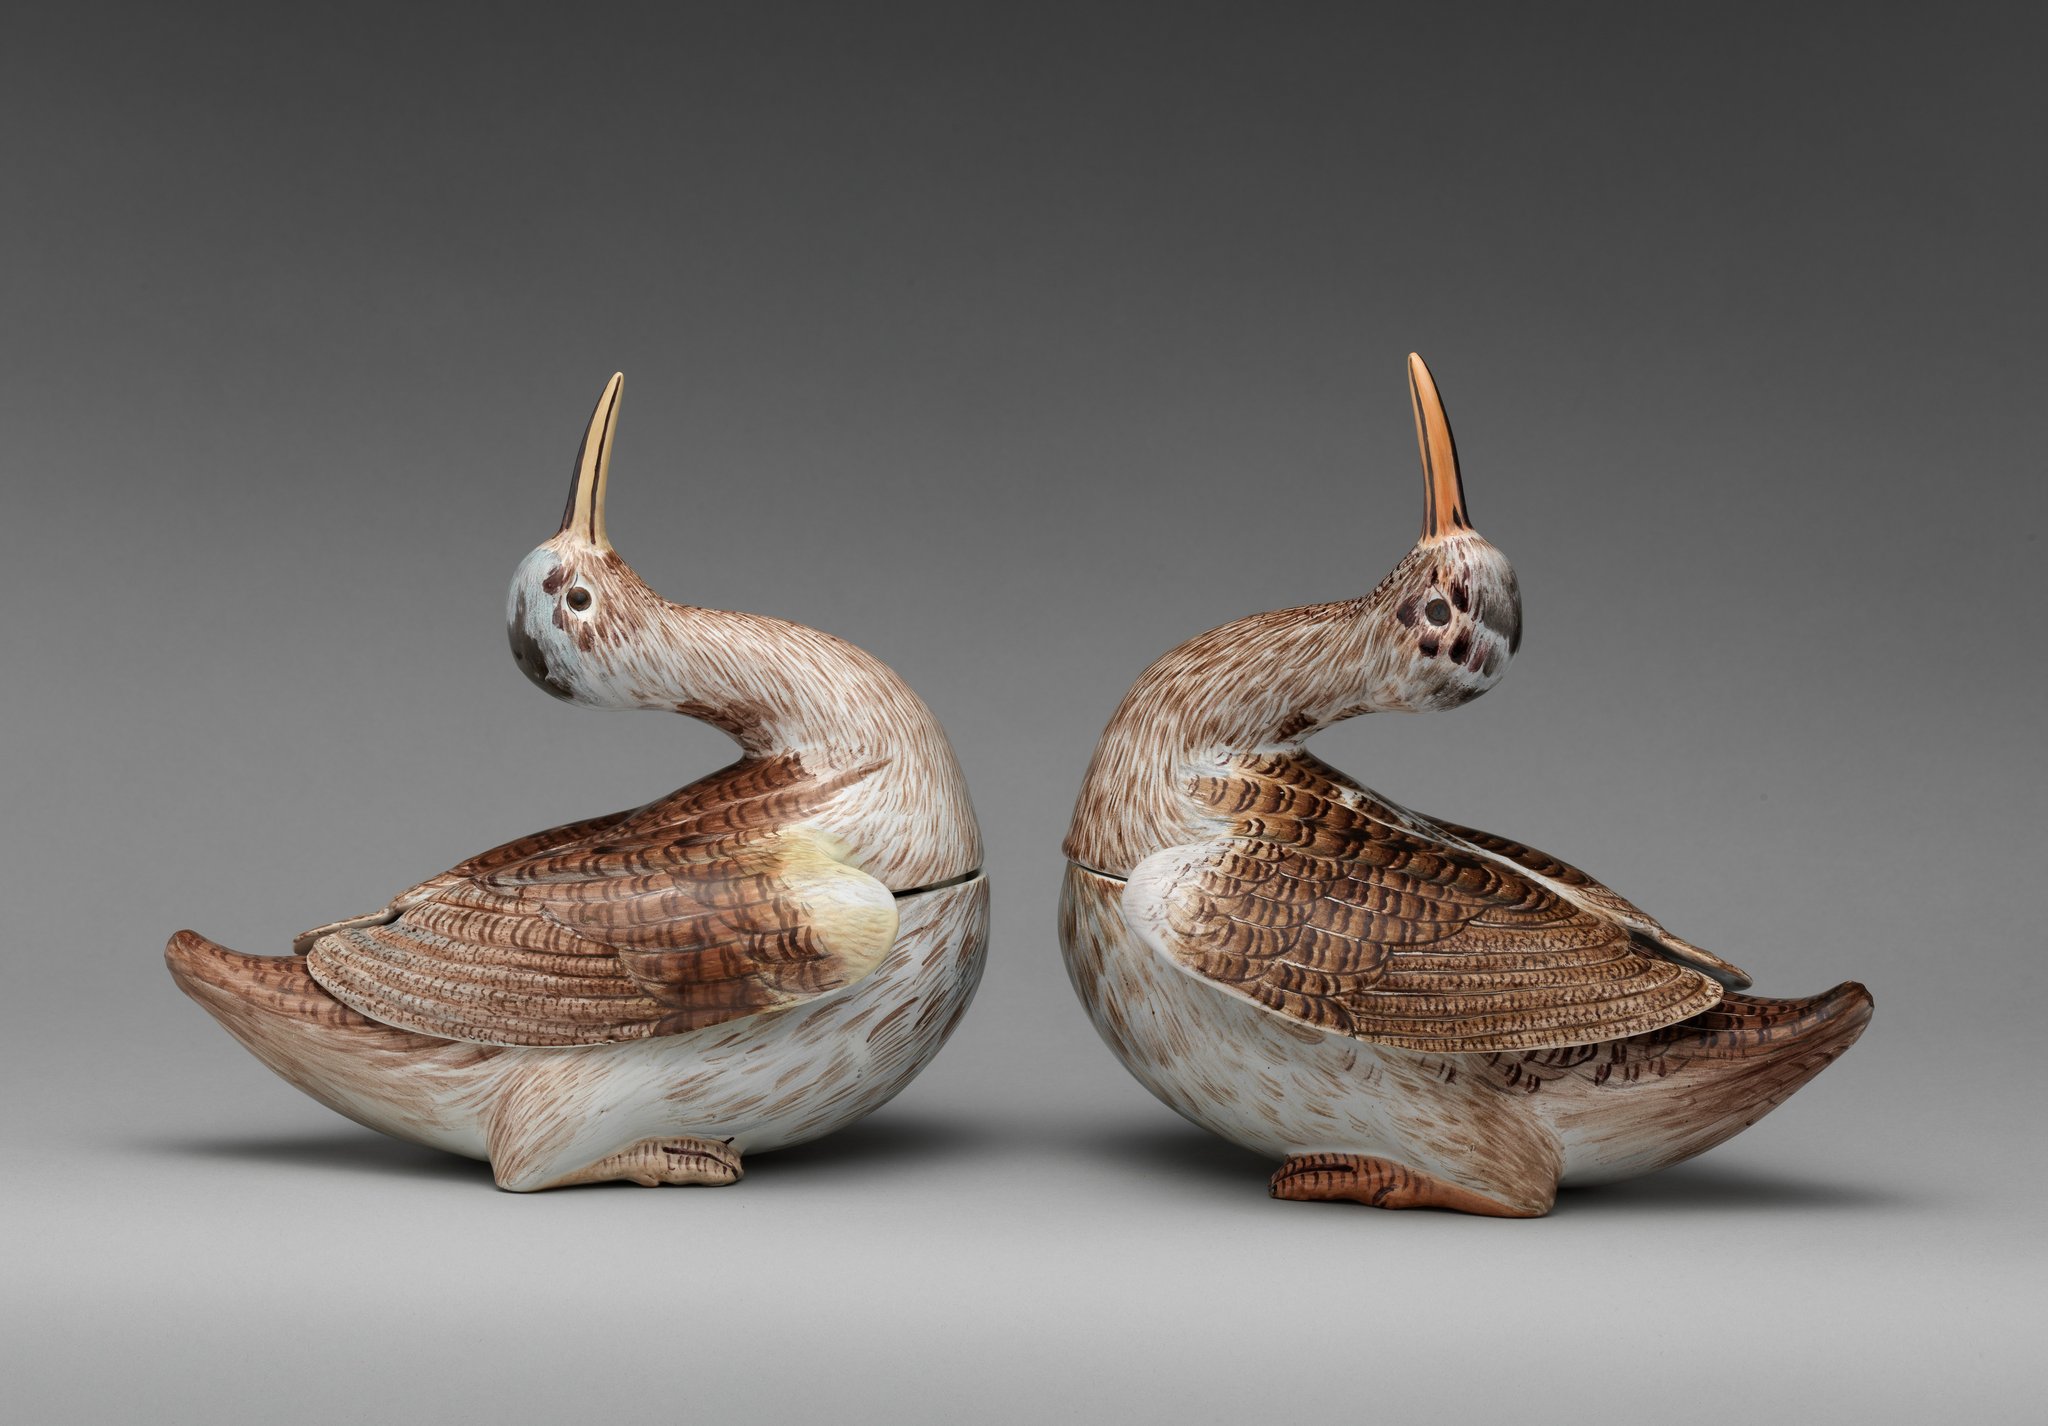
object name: tureen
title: Tureen in the form of a woodcock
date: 1750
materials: earthenware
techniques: glazing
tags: birds